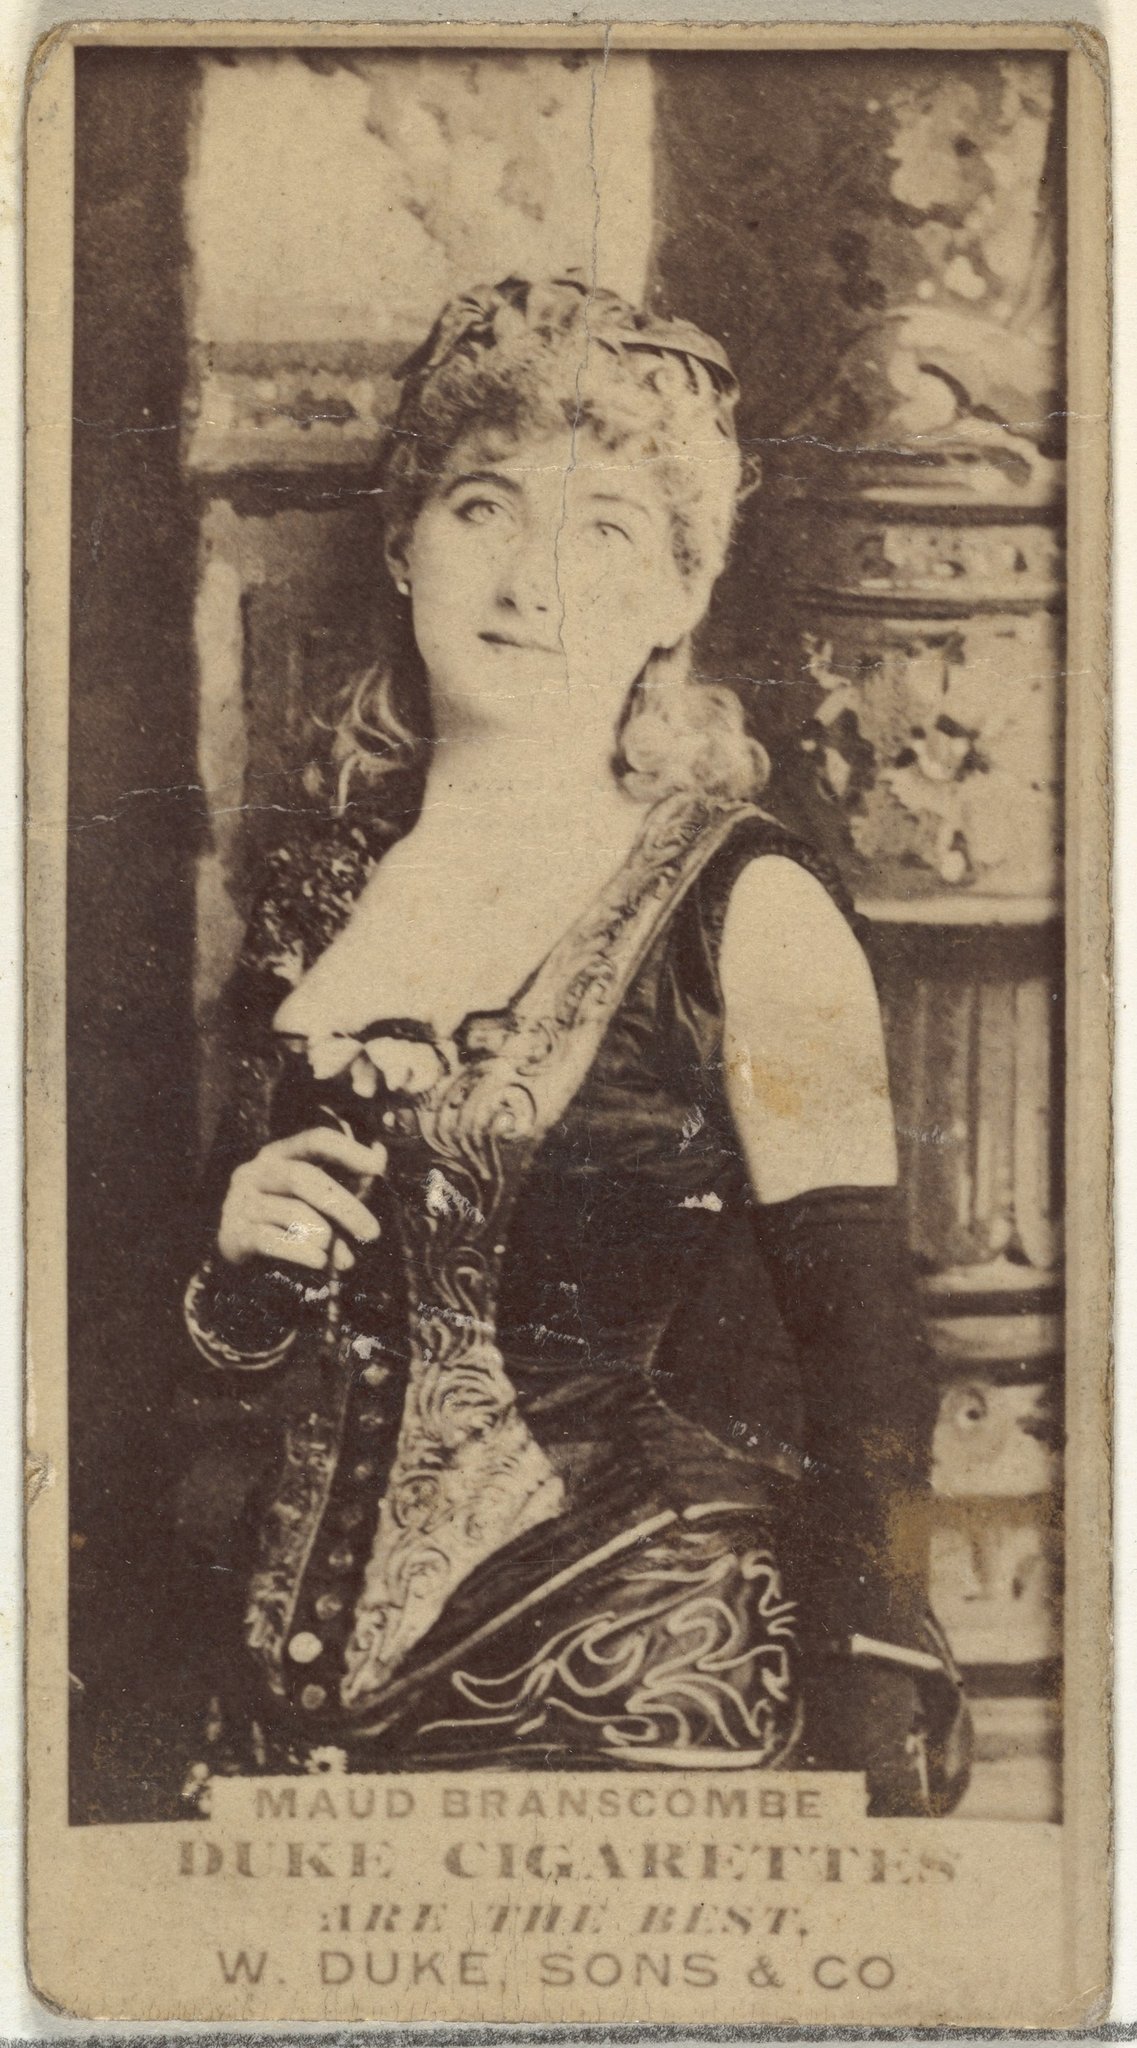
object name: photograph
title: Maud Branscombe, from the Actors and Actresses series (N145-7) issued by Duke Sons & Co. to promote Duke Cigarettes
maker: w. duke, sons & co.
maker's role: publisher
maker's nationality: american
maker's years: 1870-1920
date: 1880-1889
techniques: albumen silver print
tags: portraits,women,actresses